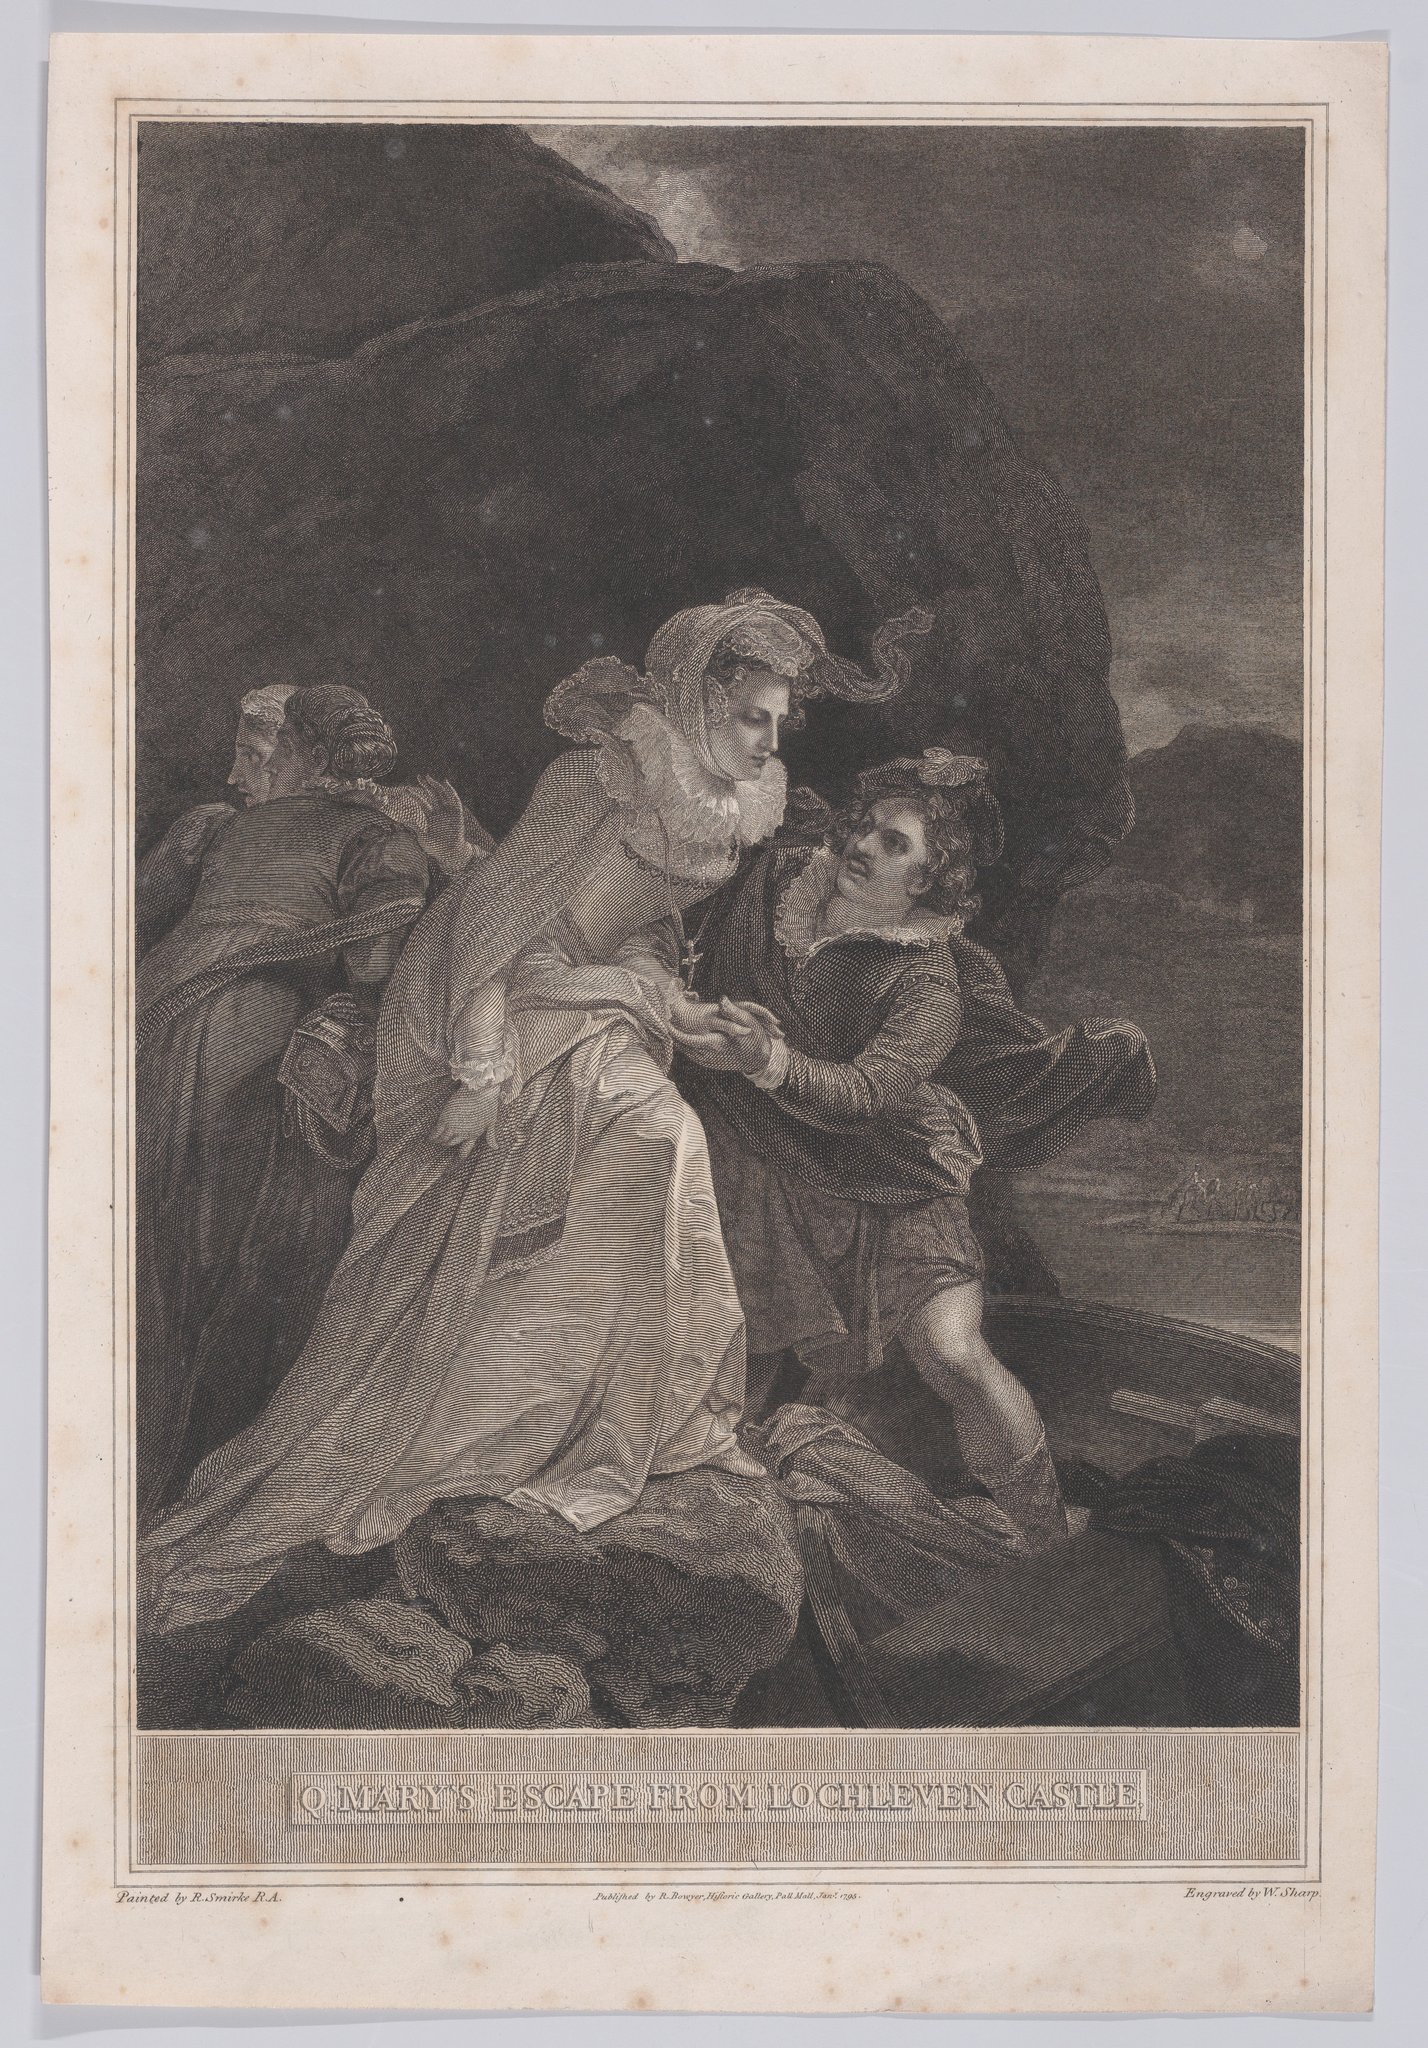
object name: print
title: Mary, Queen of Scots escaping Lochleven Castle (from "The History of England")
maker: william sharp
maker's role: artist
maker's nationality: british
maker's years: 1749-1824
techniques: engraving, etching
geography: england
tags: queens,men,women,boats,mary queen of scots